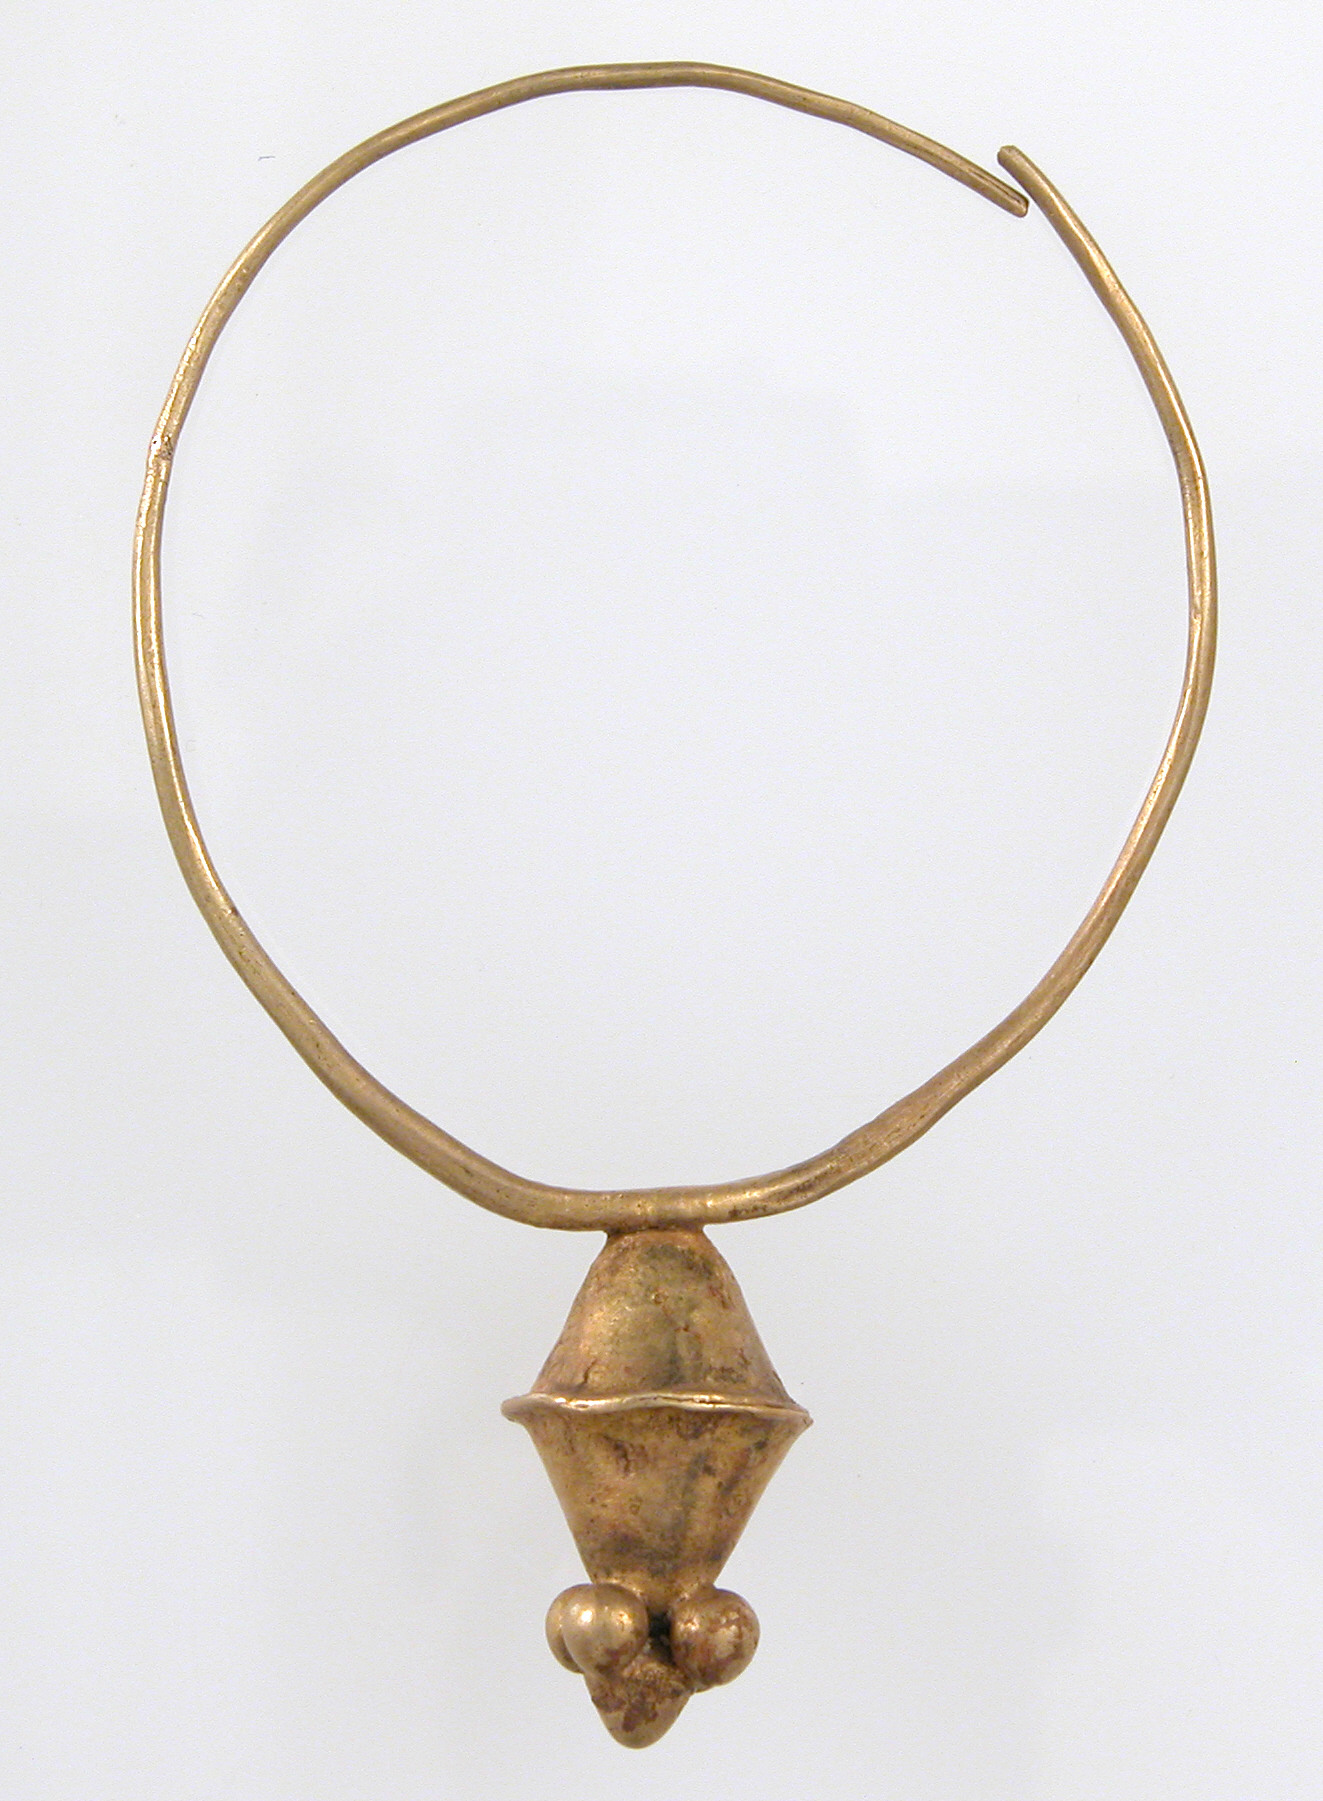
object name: earring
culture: avar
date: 201-300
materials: gold